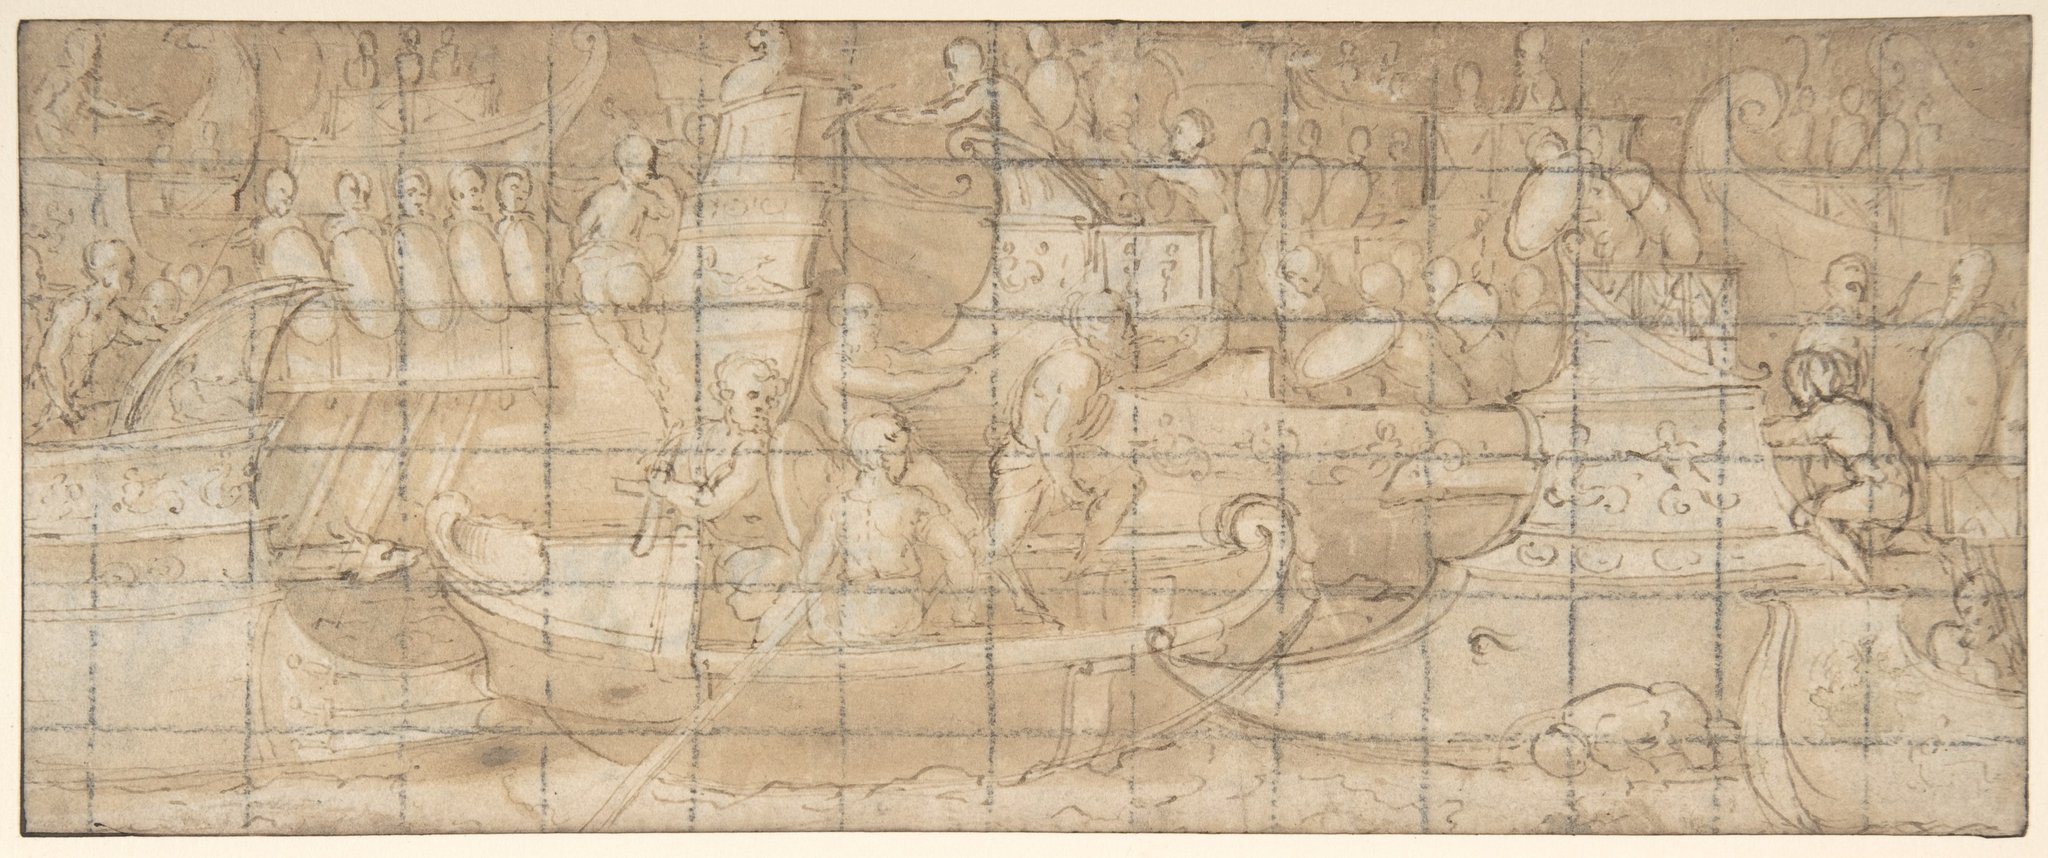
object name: drawing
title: Antique Naval Battle (recto); A Battle Scene (verso)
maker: lattanzio gambara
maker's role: artist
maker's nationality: italian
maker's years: 1525-1574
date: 1550-1555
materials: chalk, ink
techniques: brush, pen, drawing, wash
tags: battles,crowd,boats